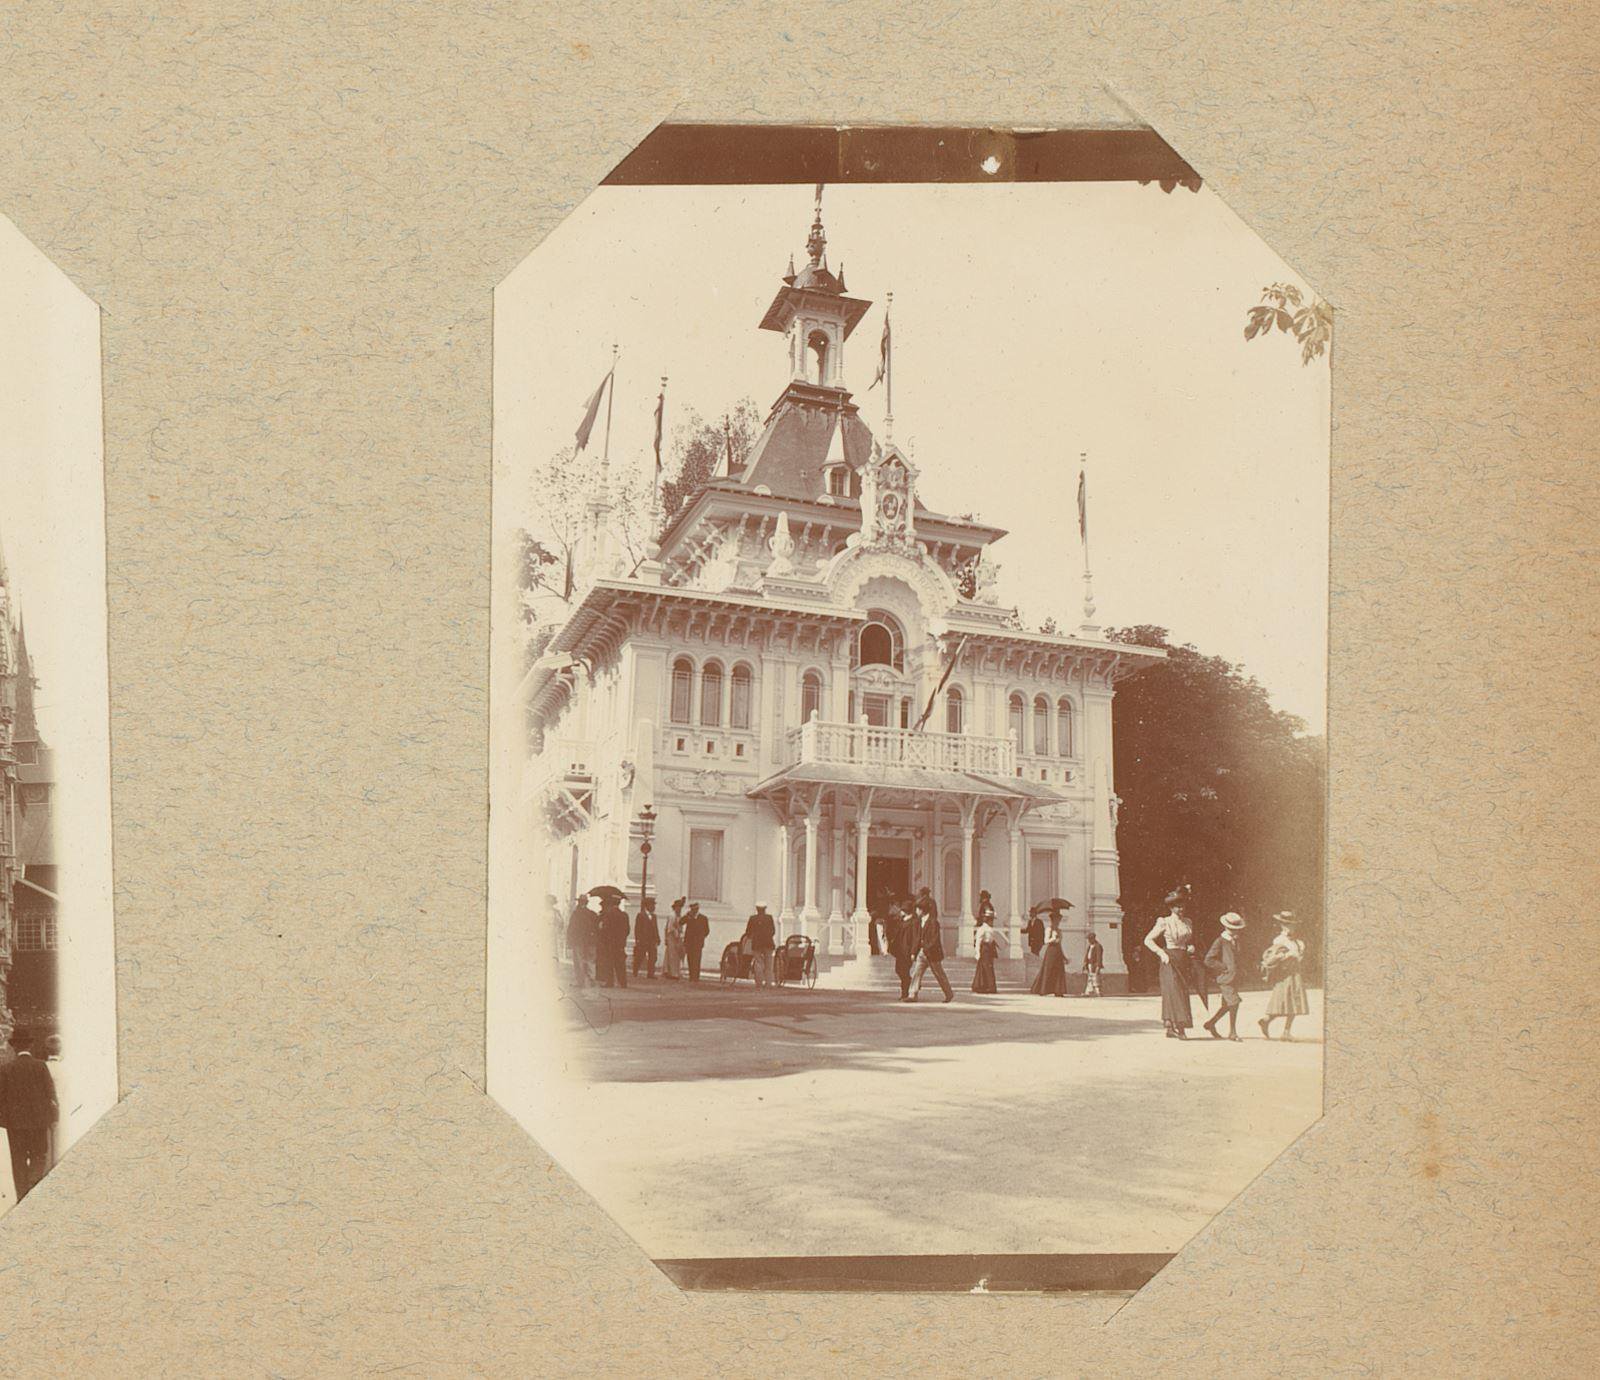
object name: album leaf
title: Paviljoen van Transvaal op de Wereldtentoonstelling van 1900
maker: Anonymous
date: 1900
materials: paper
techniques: gelatin silver print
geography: paris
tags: world fair, world exhibition, paris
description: Over de foto is een ander negatief afgedrukt van een voorstelling van bomen.